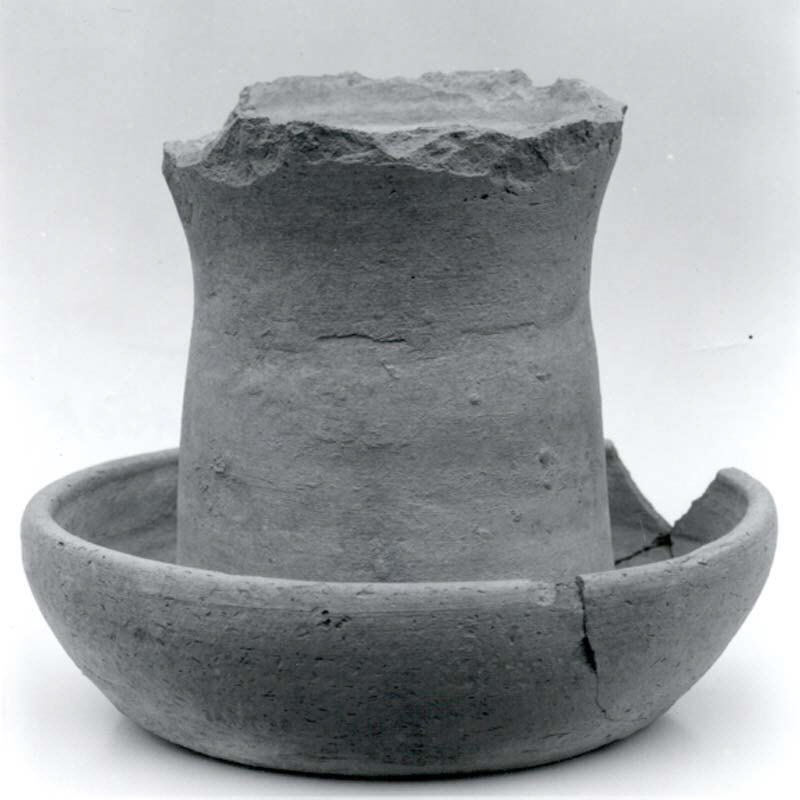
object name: stand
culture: sasanian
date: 201-700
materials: ceramic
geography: iran